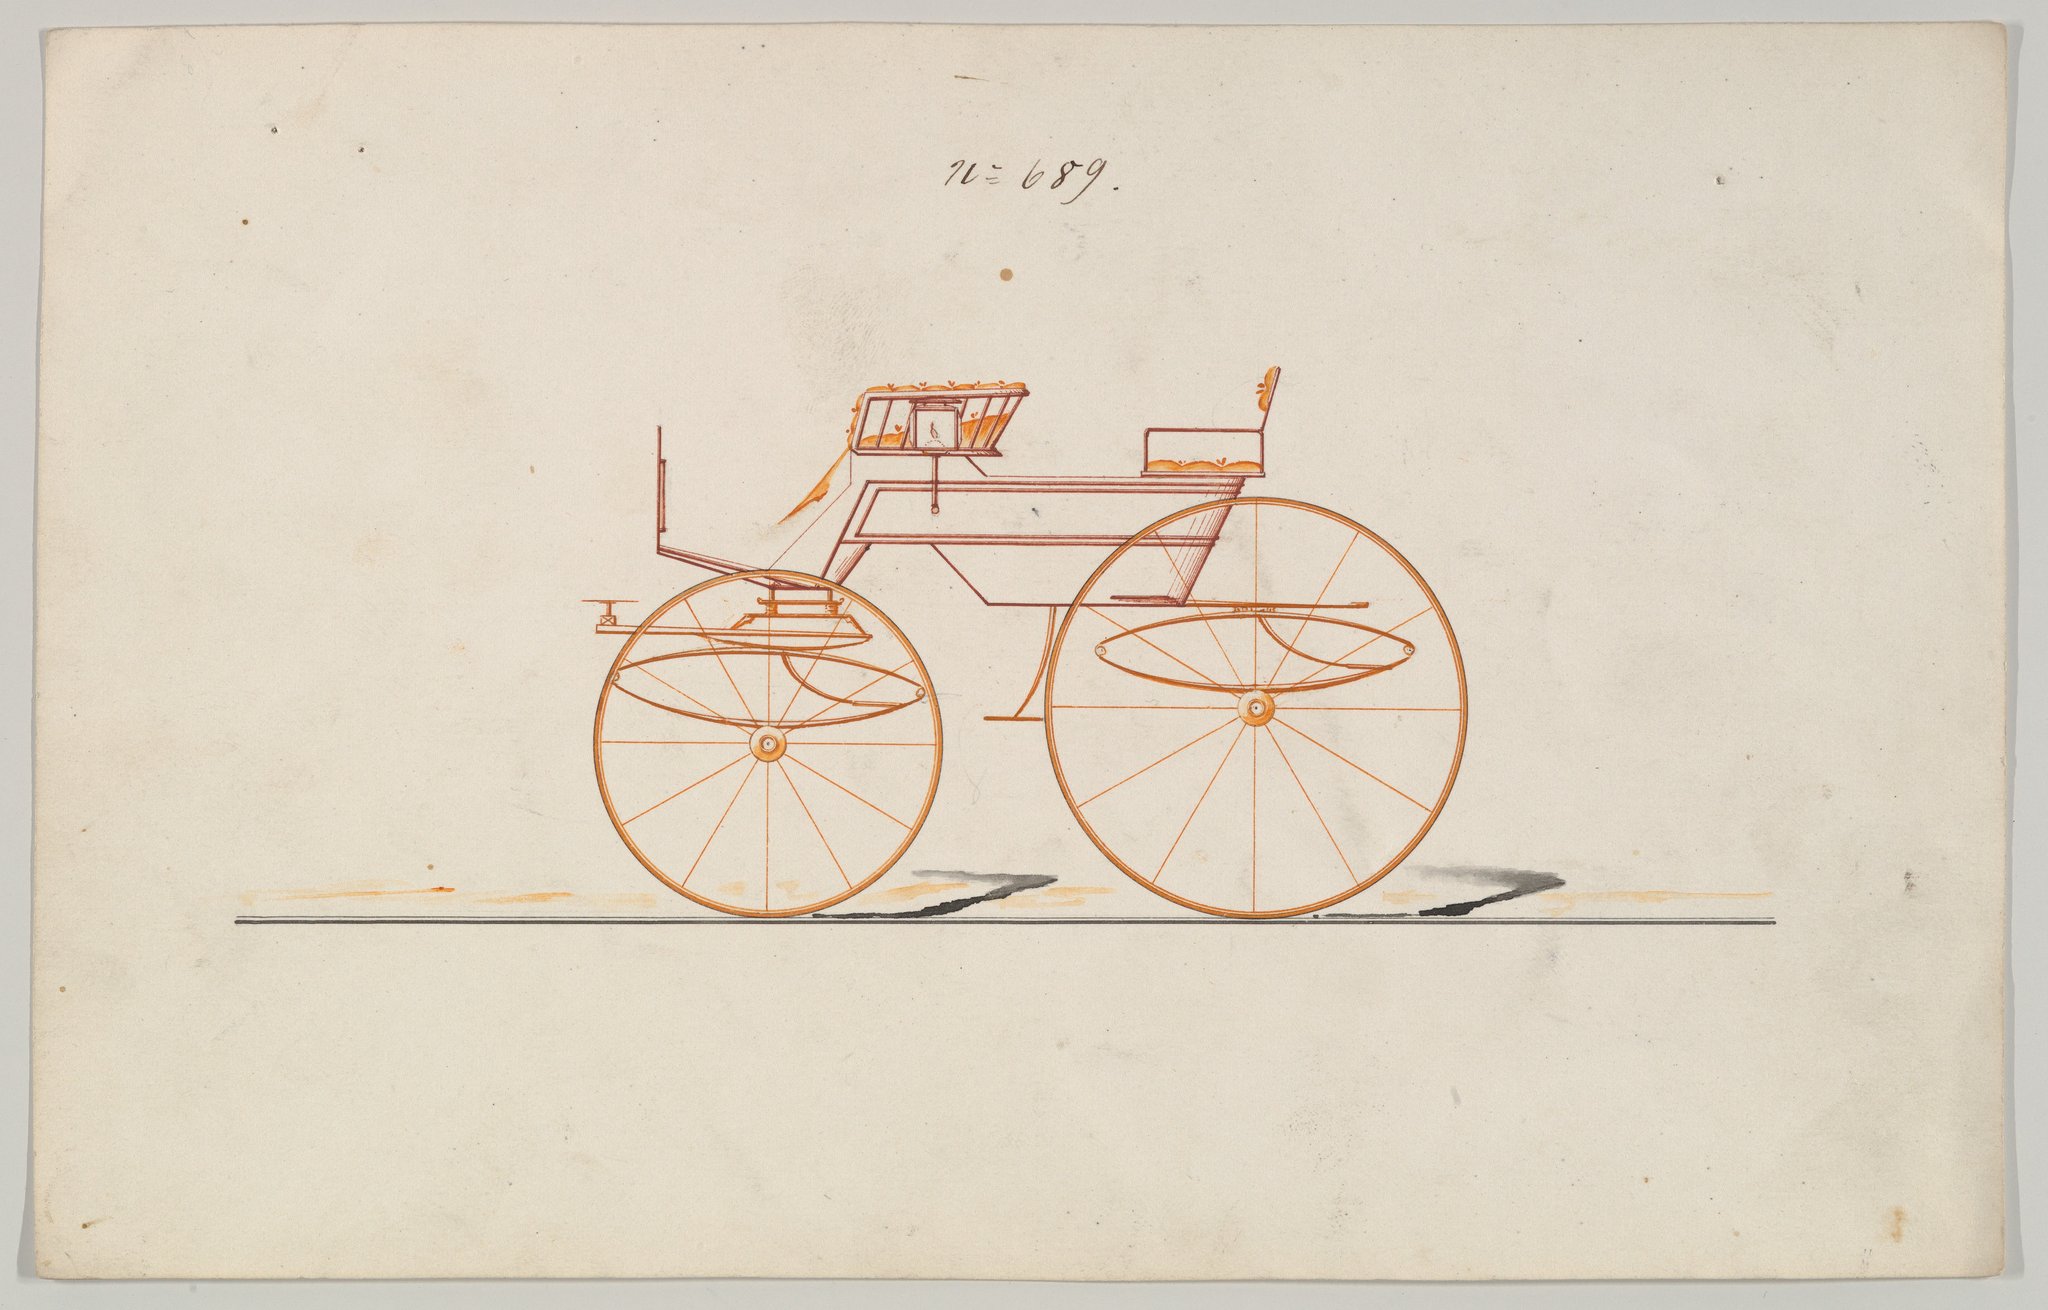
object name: drawing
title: Phaeton # 689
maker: brewster & co.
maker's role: manufacturer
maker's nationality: american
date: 1850-1870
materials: watercolor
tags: carriages